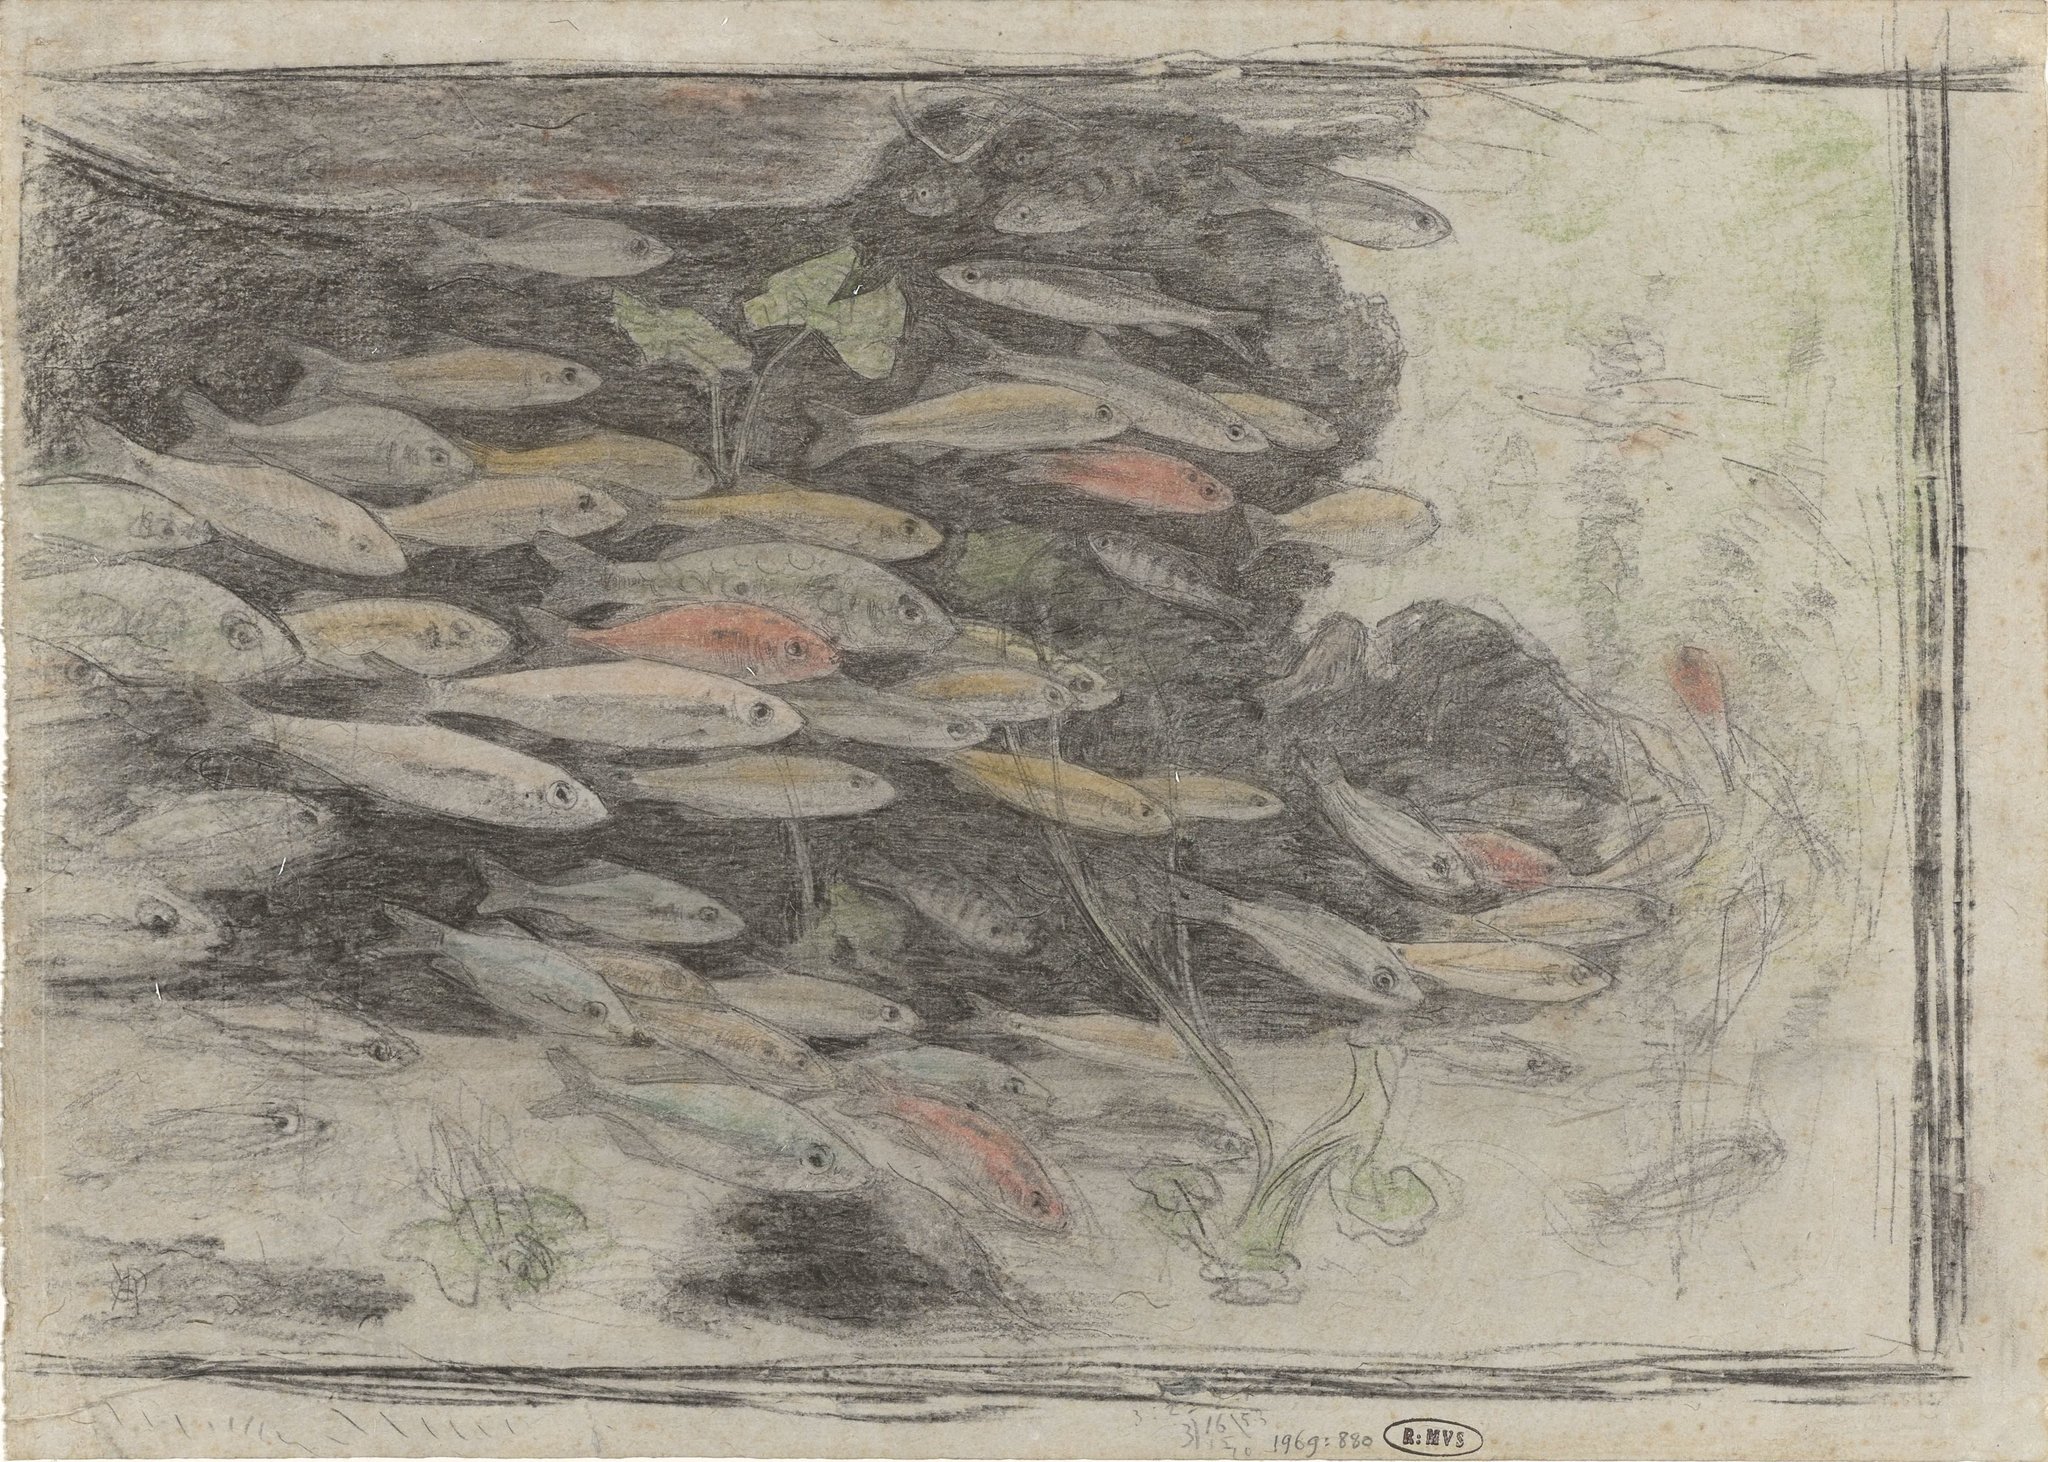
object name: drawing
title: Aquarium met goudwinden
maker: gerrit willem dijsselhof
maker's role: designer, draughtsman, print maker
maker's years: 1866-1924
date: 1876-1924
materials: chalk, paper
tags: aquarium